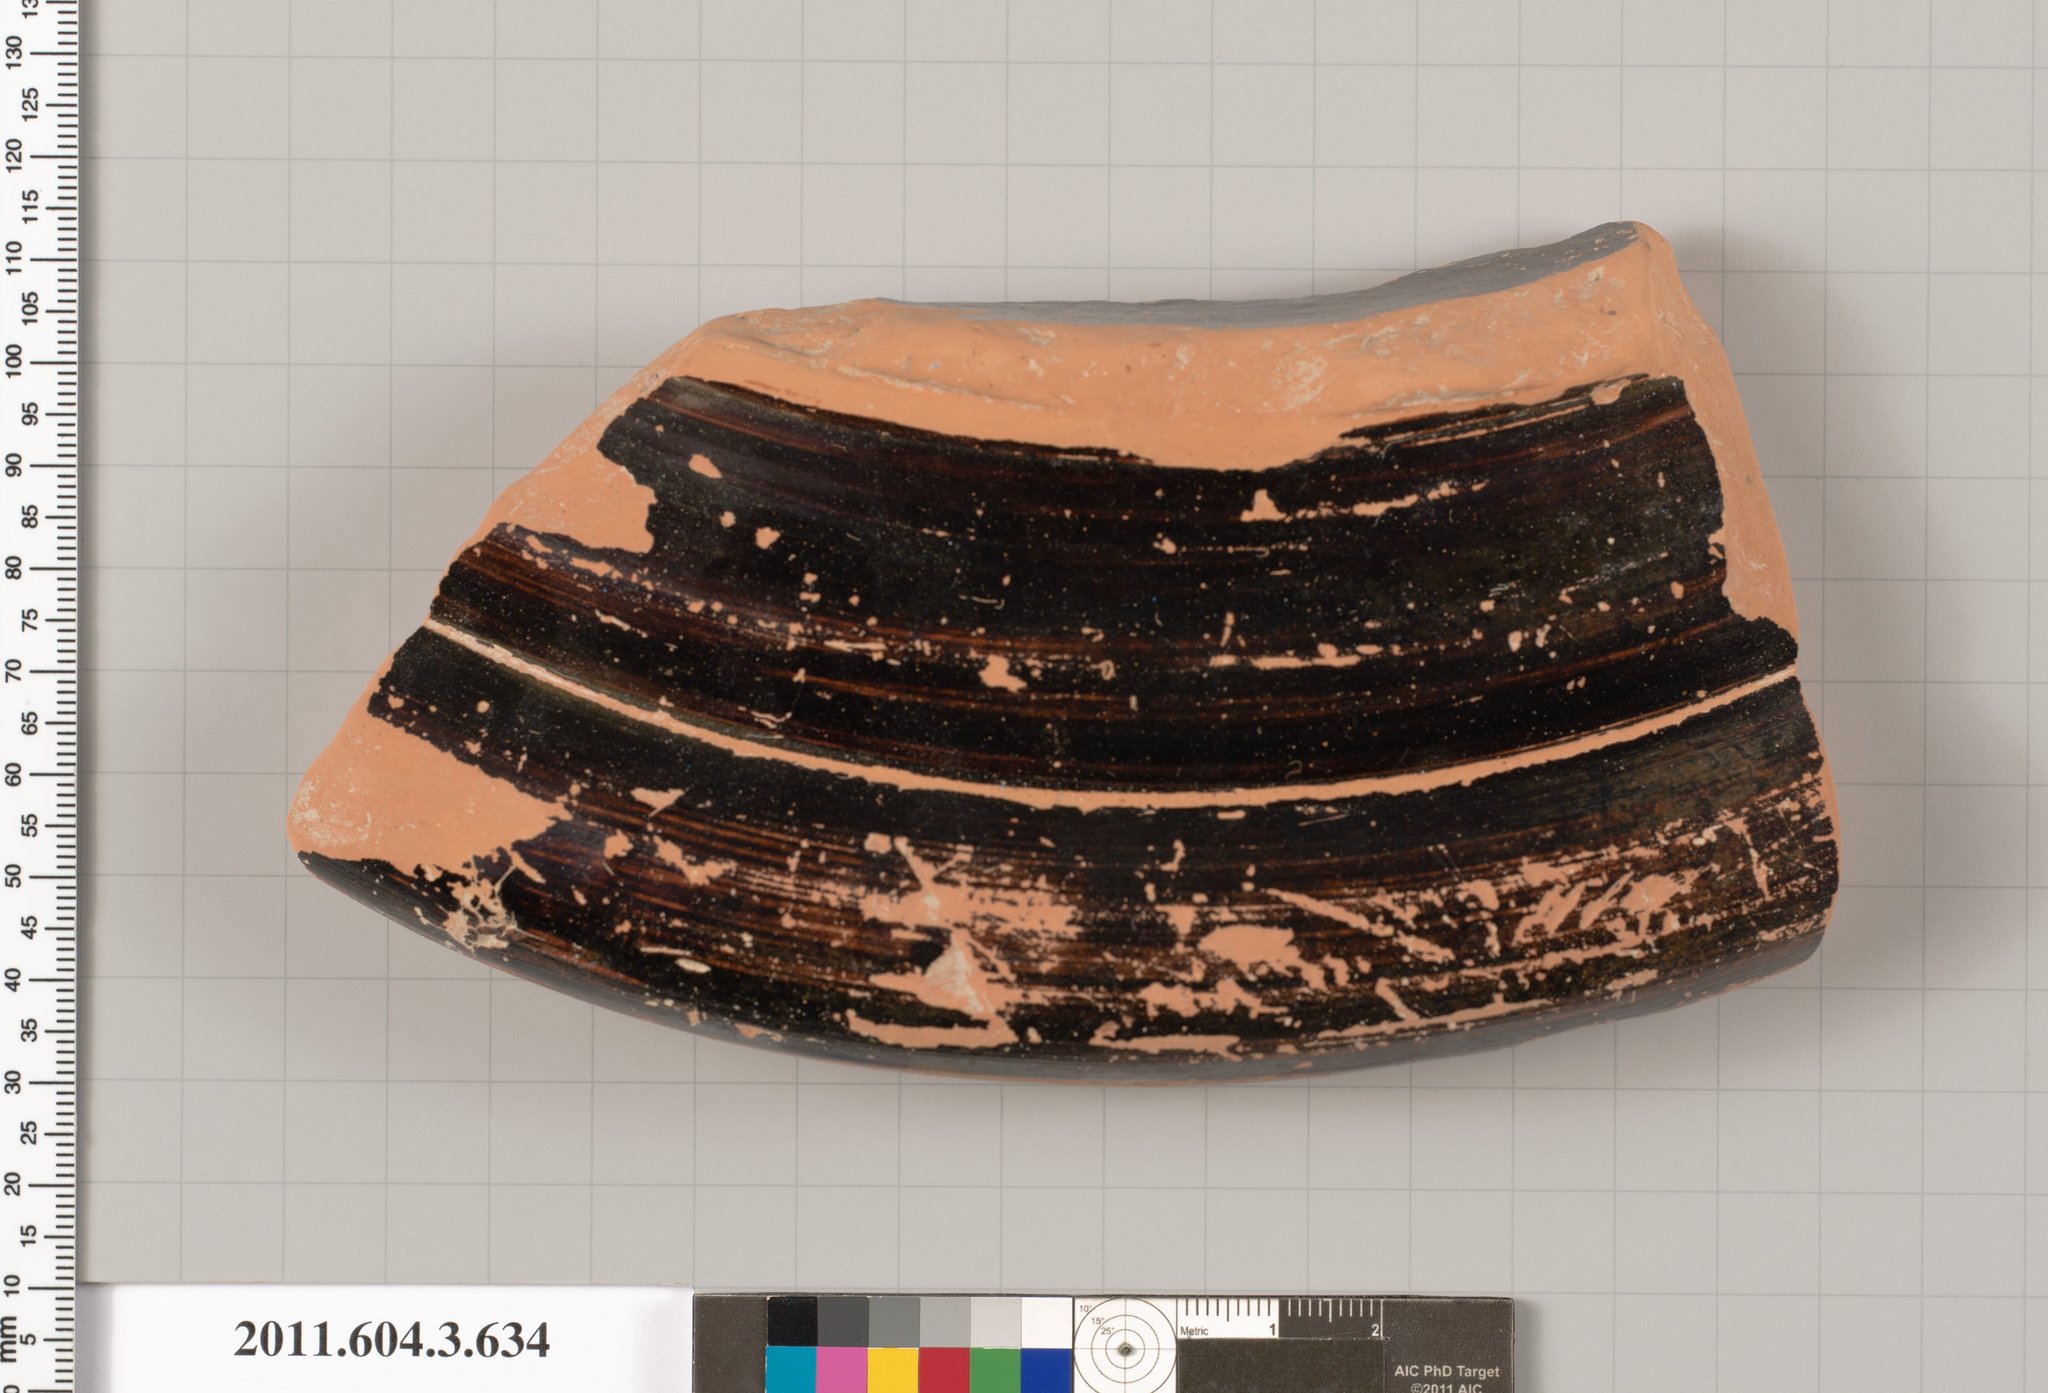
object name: column krater fragment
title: Terracotta fragment of a column-krater (bowl for mixing wine and water)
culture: greek, attic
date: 600-401 BCE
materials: terracotta